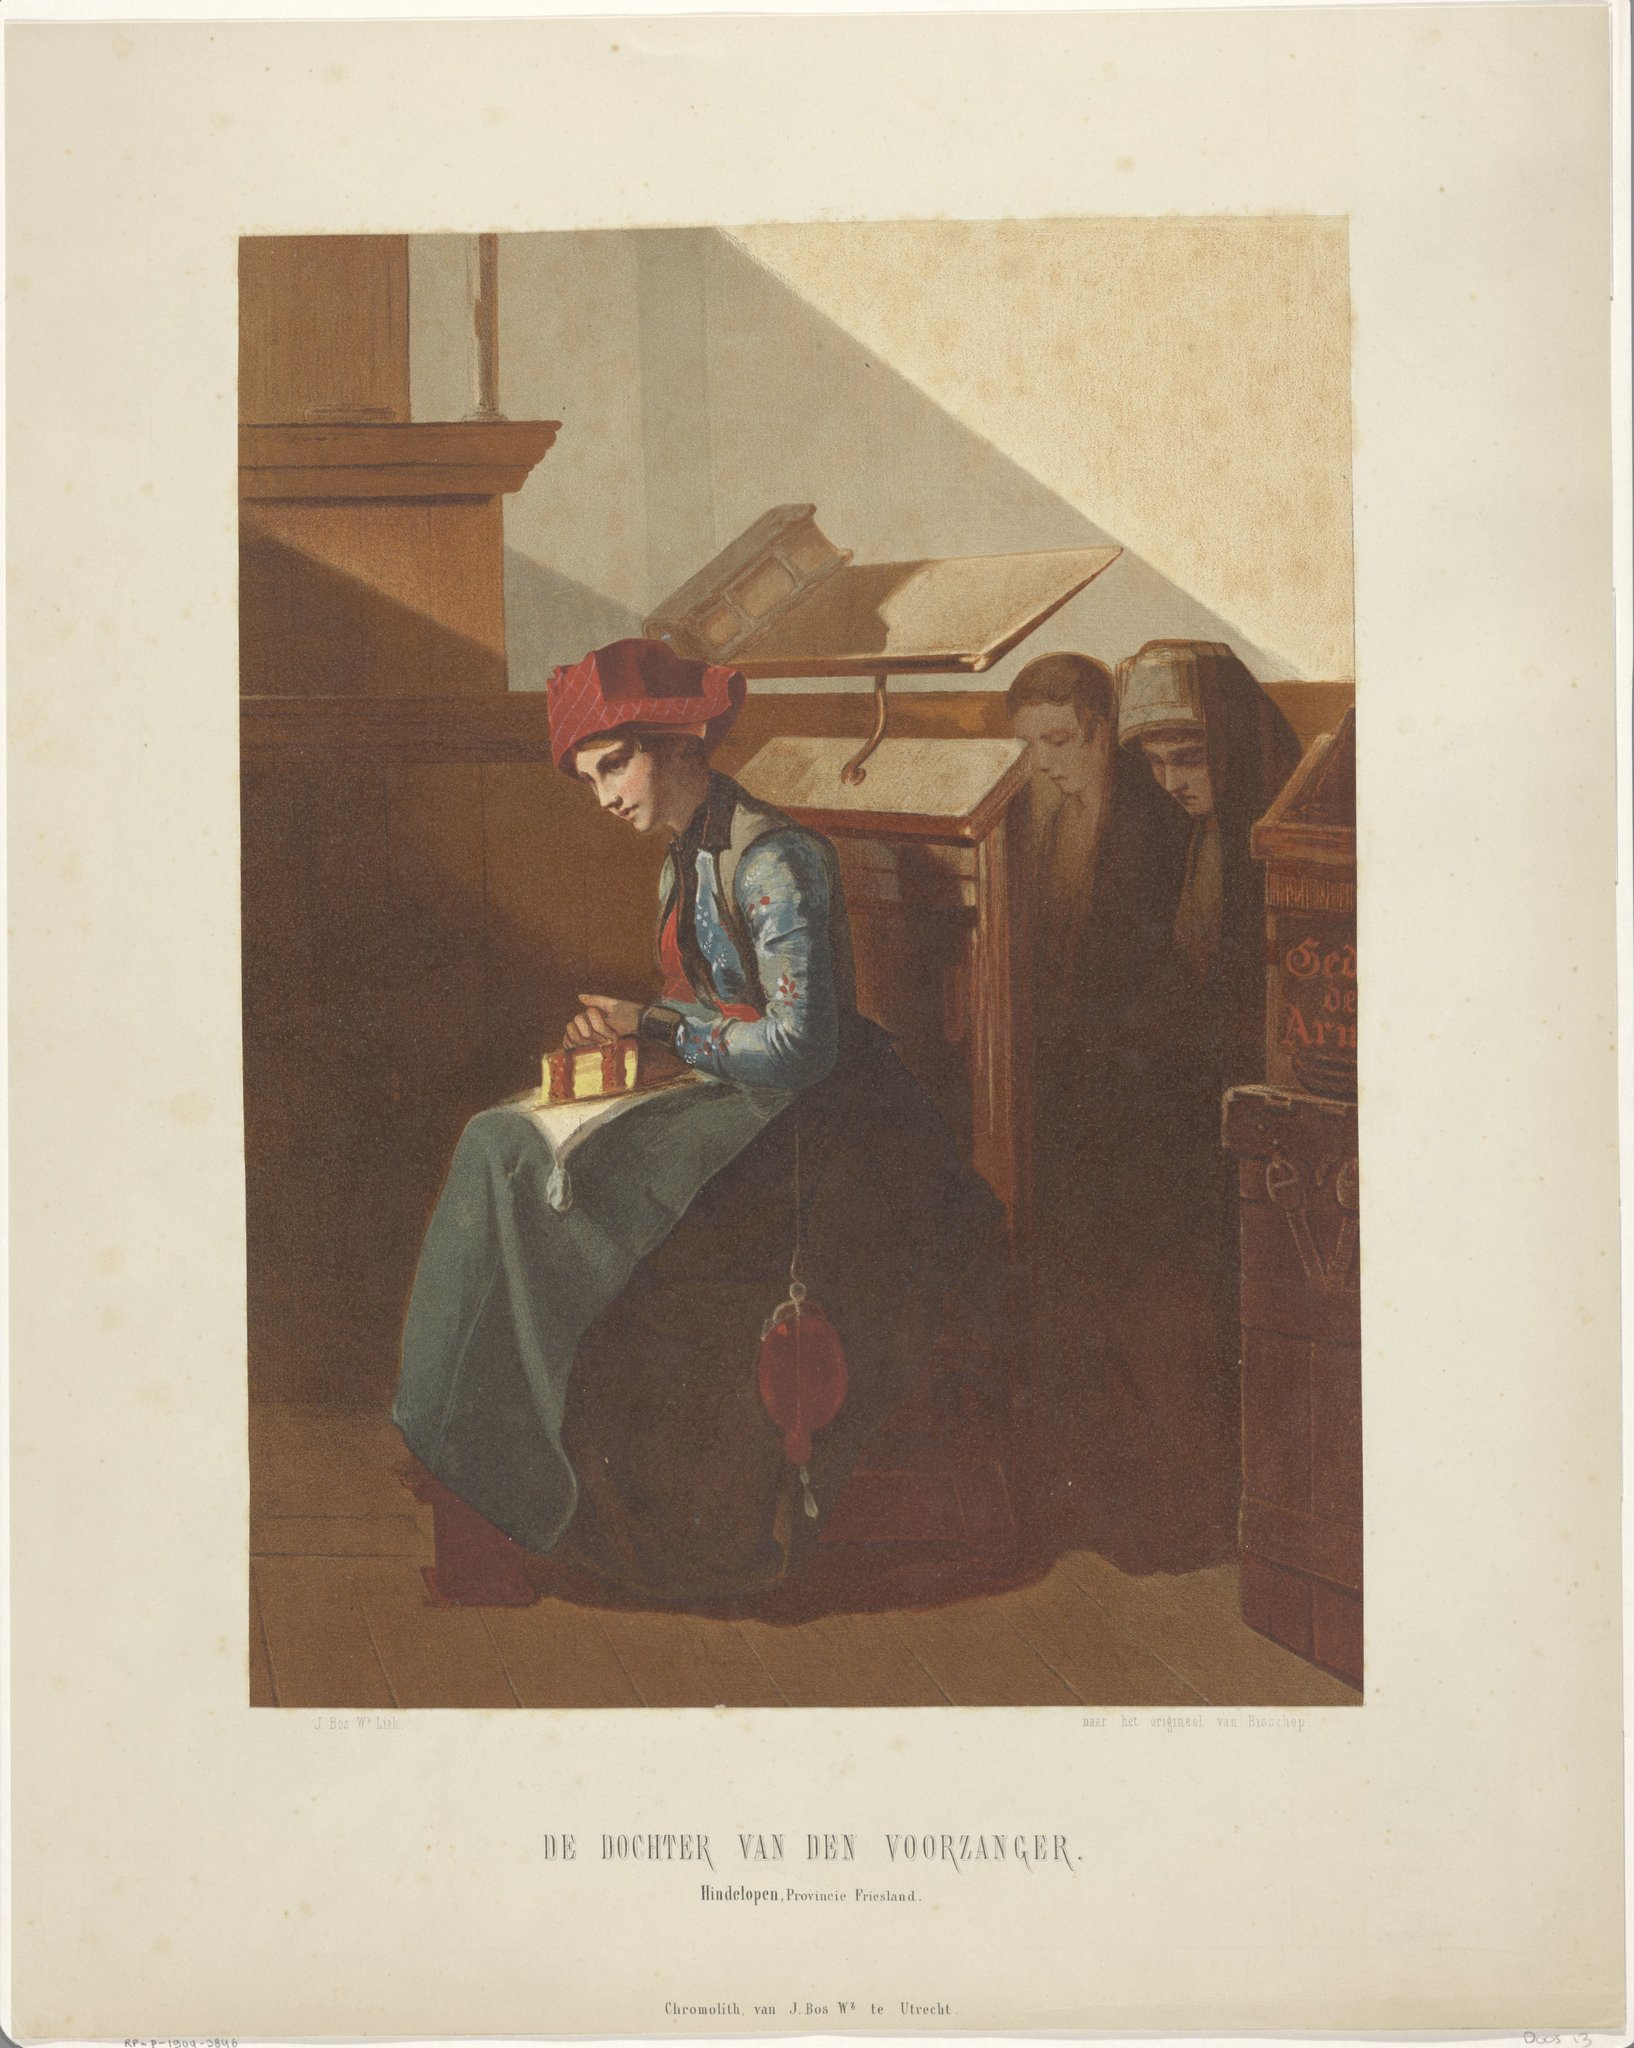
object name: print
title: Hindeloopen vrouw in kerkinterieur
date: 1842-1897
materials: paper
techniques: oleograph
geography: netherlands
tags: (public) prayer, interior of church, sitting on an elevation - aa - female human figure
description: In een kerk, op een houten bankje voor een spreekstoel, zit een meisje met een rode muts. Haar handen heeft zij gevouwen in haar schoot op een boek. Aan haar heup hangt een rode tas. Achter haar, in de kerkbanken, zitten twee figuren met het hoofd gebogen. Naar een schilderij door Christoffel Bisschop.